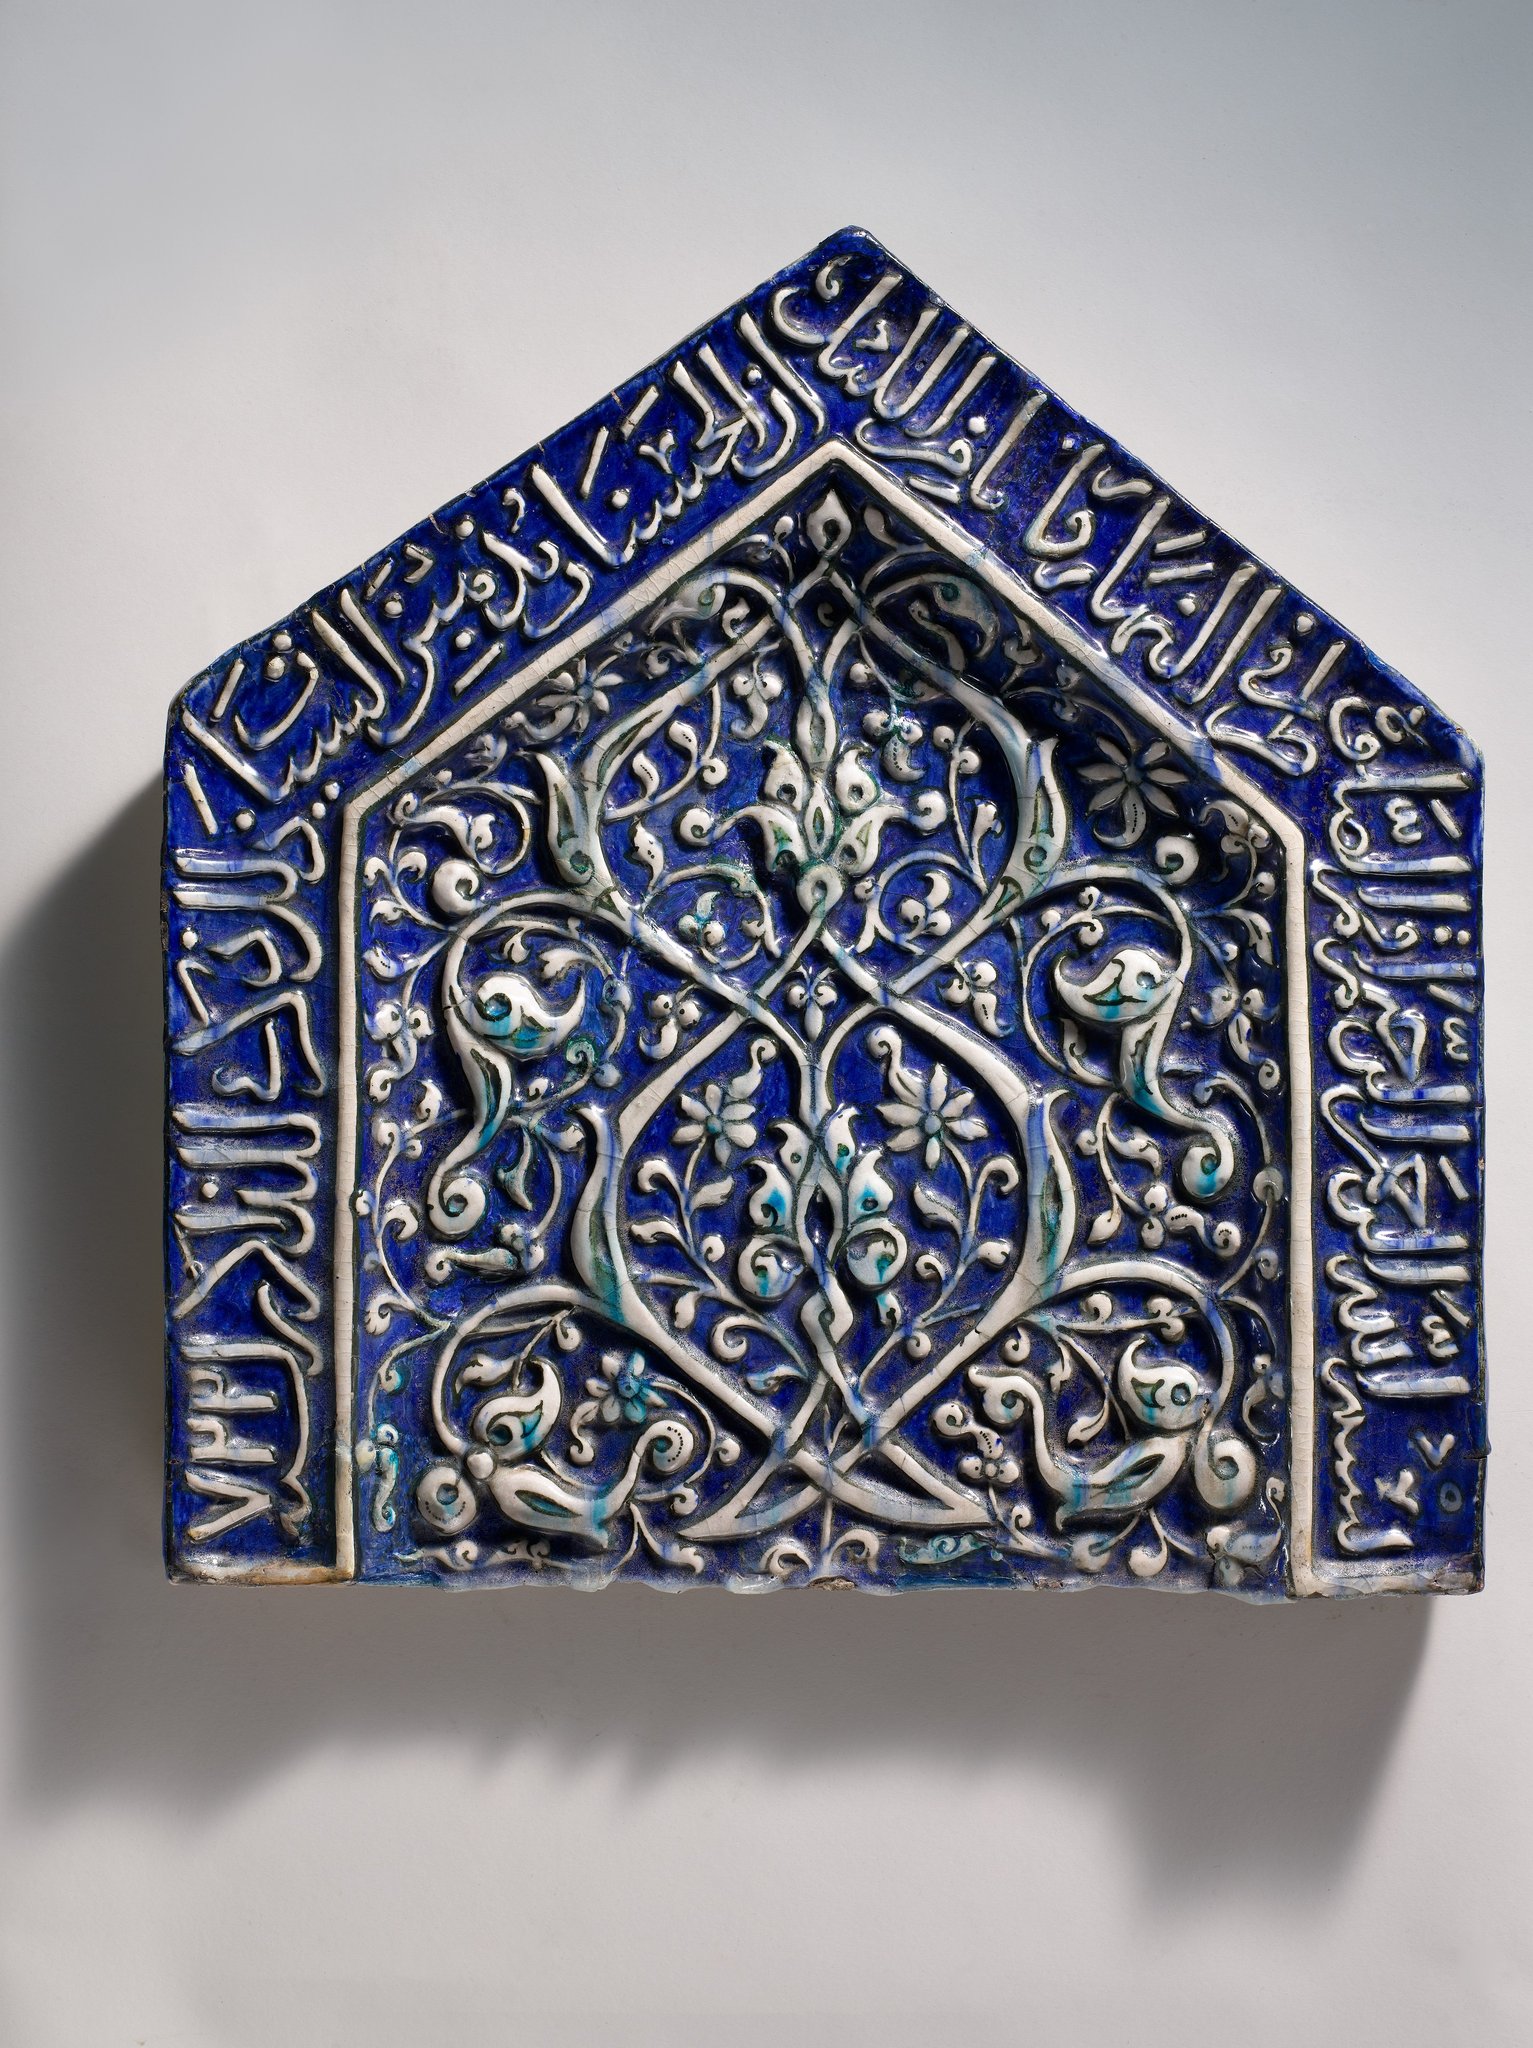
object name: tile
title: Tile from a Mihrab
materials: glaze, stonepaste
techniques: painting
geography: iran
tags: arabic